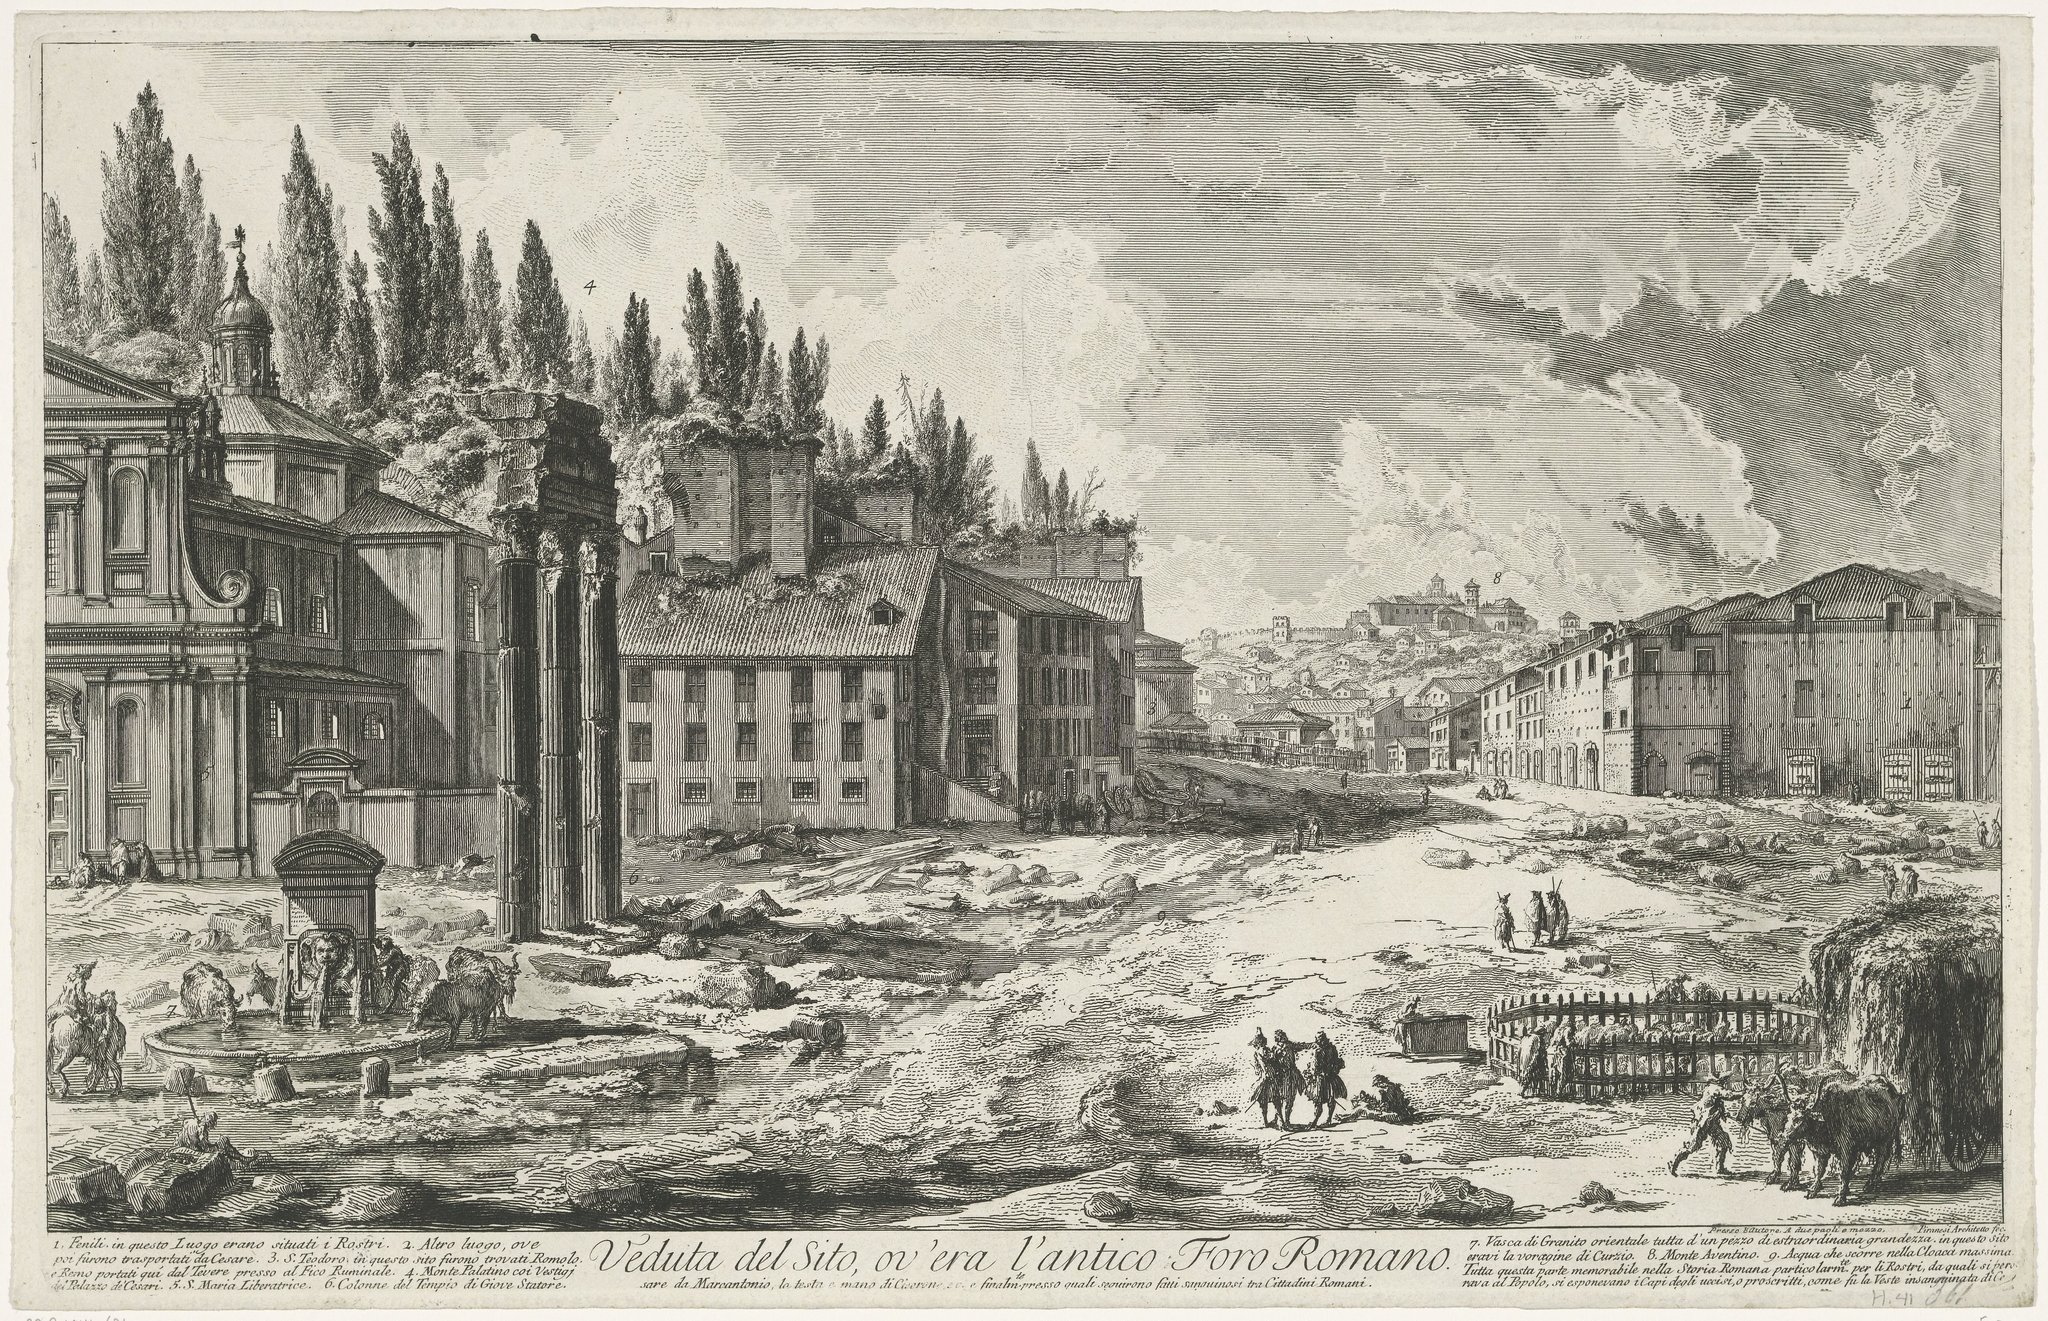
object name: print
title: Vedute di Roma disegnate ed incise da Giambattista Piranesi architetto Ve(nez)iano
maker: giovanni battista piranesi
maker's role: designer, draughtsman, print maker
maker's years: 1720-1778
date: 1748-1778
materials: paper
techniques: etching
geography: rome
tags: ruin of a building ~ architecture, landscape with ruins, temple, shrine ~ roman religion, rome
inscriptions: collector's mark: Lugt 2228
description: Deze prent maakt deel uit van de serie 'Vedute di Roma'. Piranesi werkte aan deze 135 platen tellende serie tussen 1748 en zijn dood in 1778. Francesco Piranesi voegde later nog twee prenten toe aan de reeks van zijn vader.